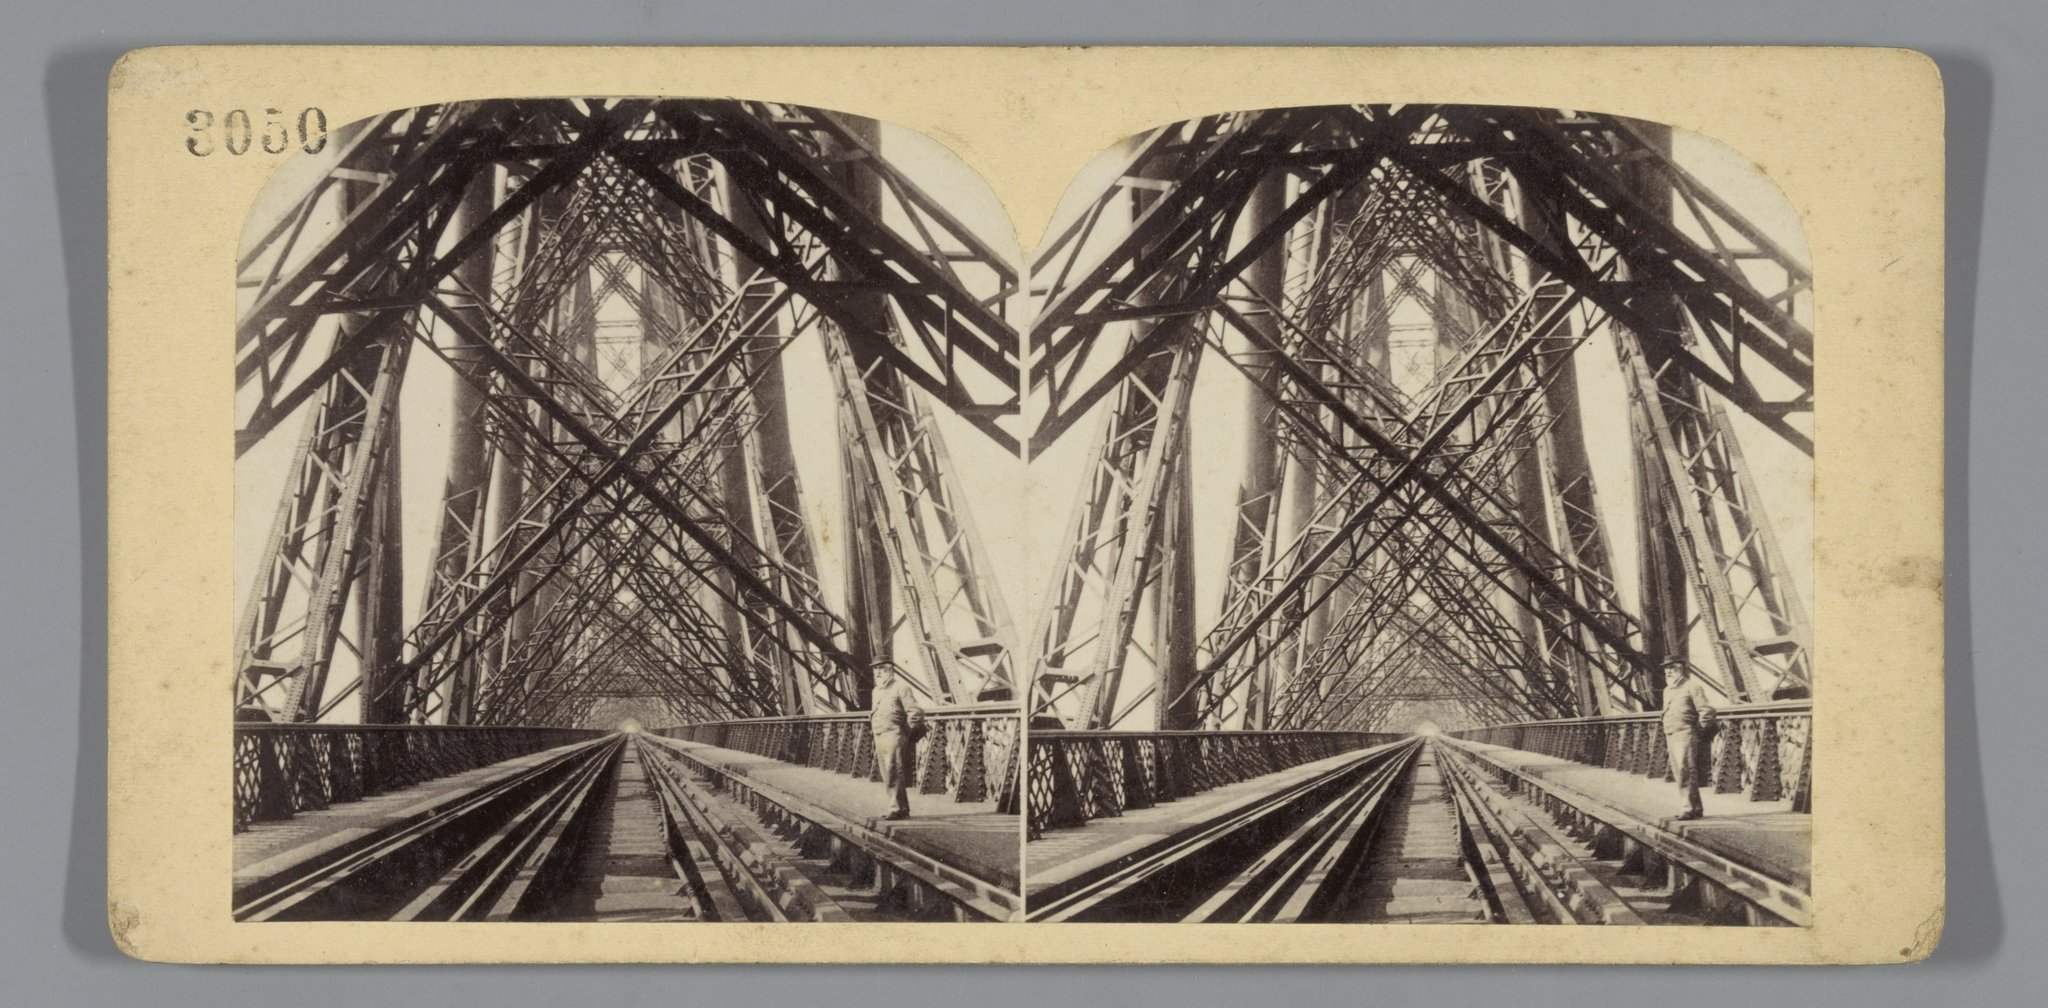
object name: stereograph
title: Gezicht op een ijzeren spoorbrug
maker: Anonymous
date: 1879-1910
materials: cardboard, paper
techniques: albumen print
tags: suspension bridge, railway, train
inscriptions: number: ‘3050’